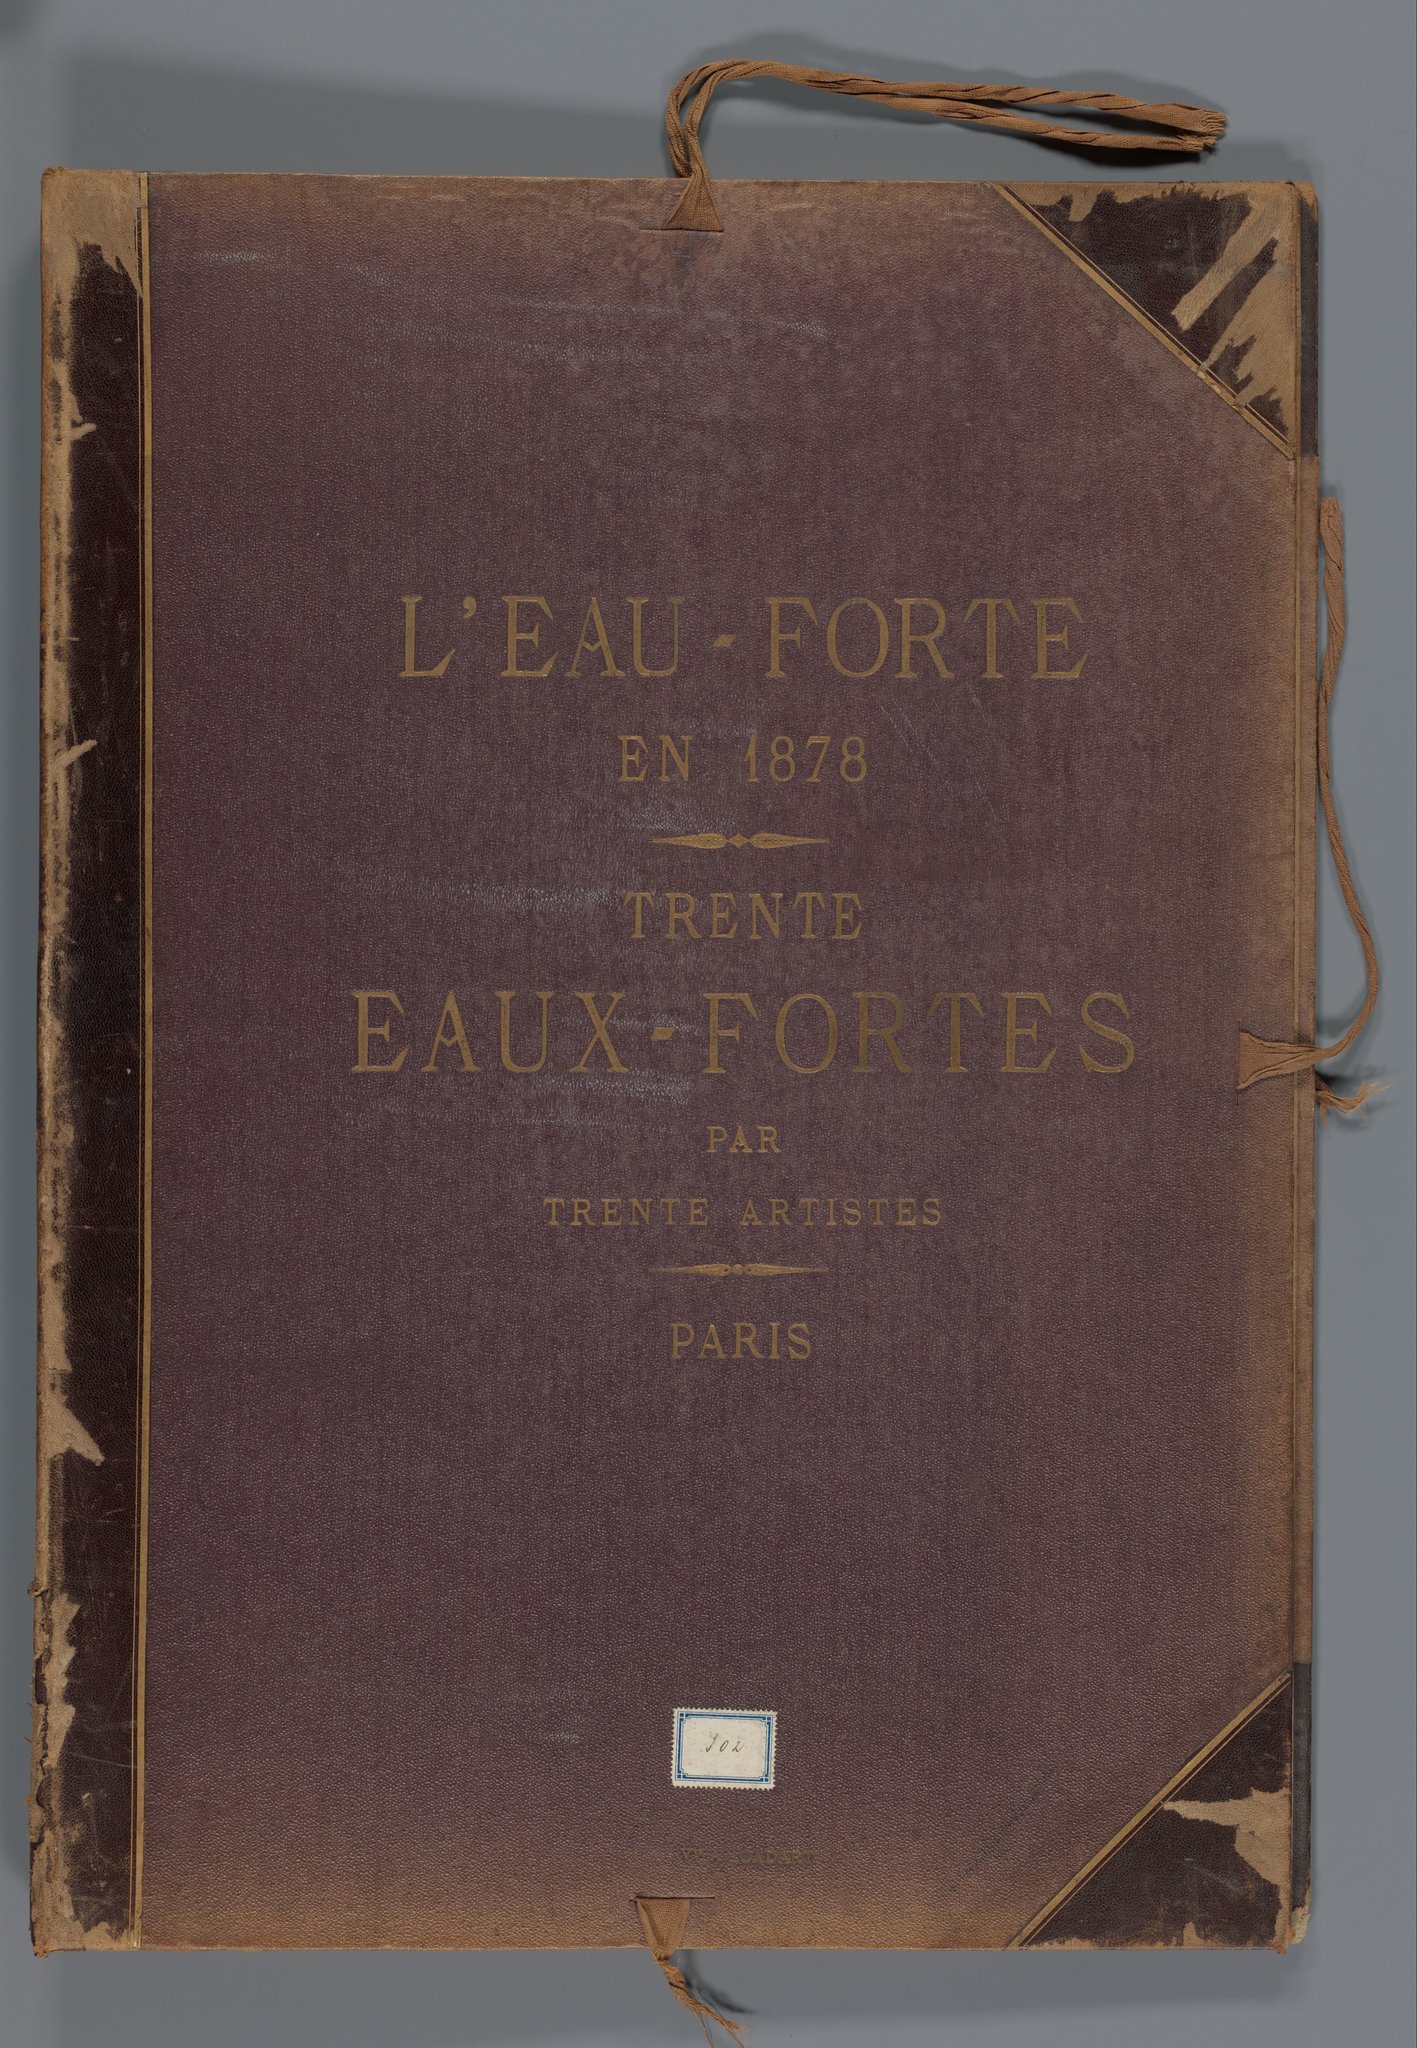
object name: wrapper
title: Franse etsen uit 1878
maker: weduwe alfred cadart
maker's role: printer, publisher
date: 1878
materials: cardboard, leather, paper, ribbon, textile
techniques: gold embossing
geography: paris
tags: city-view, and landscape with man-made constructions, trees, adult woman, landscapes, forest, wood, the soldier; the soldier's life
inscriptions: collector's mark: ‘AFE v S’, collector's mark: Lugt 2228, number: ‘302’, collector's mark: Lugt 2760